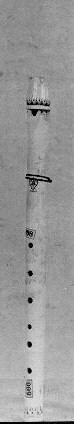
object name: vertical duct flute in d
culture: french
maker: h. boulanger et cie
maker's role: maker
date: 1801-1900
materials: porcelain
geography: france